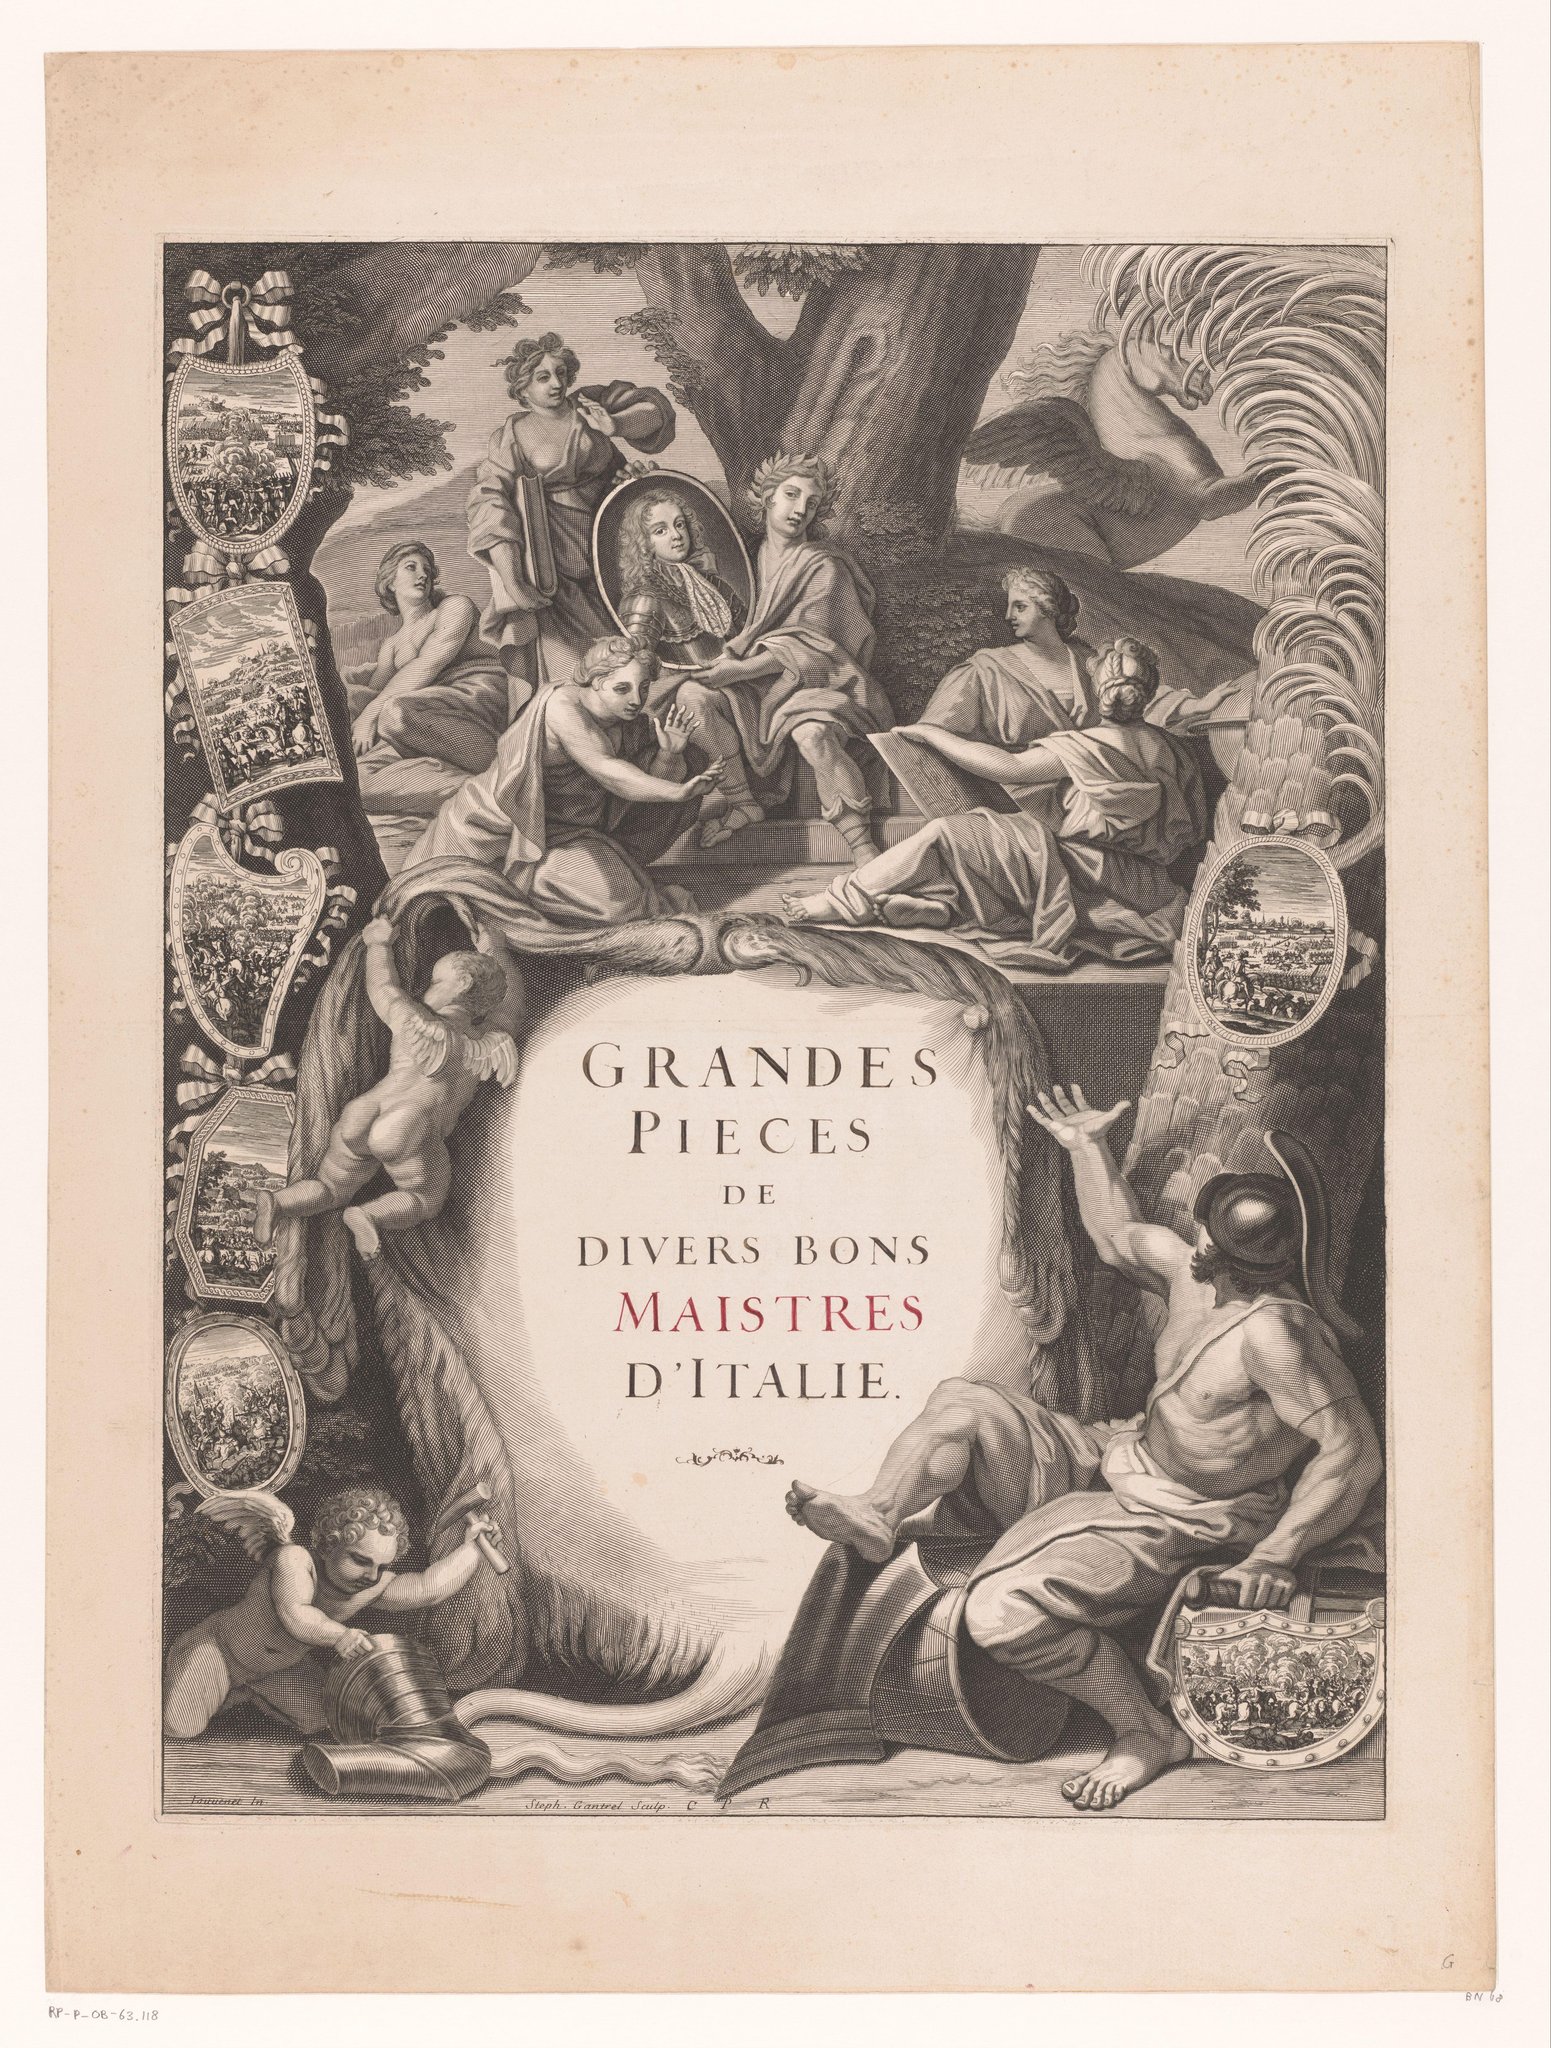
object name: print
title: Allegorische voorstelling ter ere van Louis Joseph de Bourbon-Vendôme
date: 1656-1706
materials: ink, paper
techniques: engraving, etching, pen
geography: france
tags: paris, apollo and the muses, apollo musagetes, historical persons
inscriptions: collector's mark: Lugt 240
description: Betreft mogelijk een titelpagina voor een onbekend boek met de titel 'Grandes Pieces de divers bons Maistres d'Italie'.